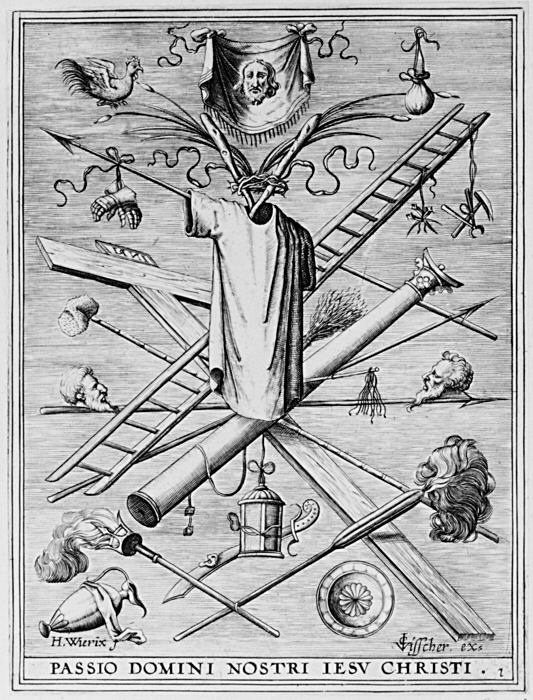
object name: print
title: Christ's Robe Surrounded by the Instruments of the Passion, from "The Passion of Christ (Passio Domni Nostri Jesu Christi)"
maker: hieronymus wierix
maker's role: artist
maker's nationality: netherlandish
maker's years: 1553-1619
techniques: engraving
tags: birds,robes,heads,christ,cross